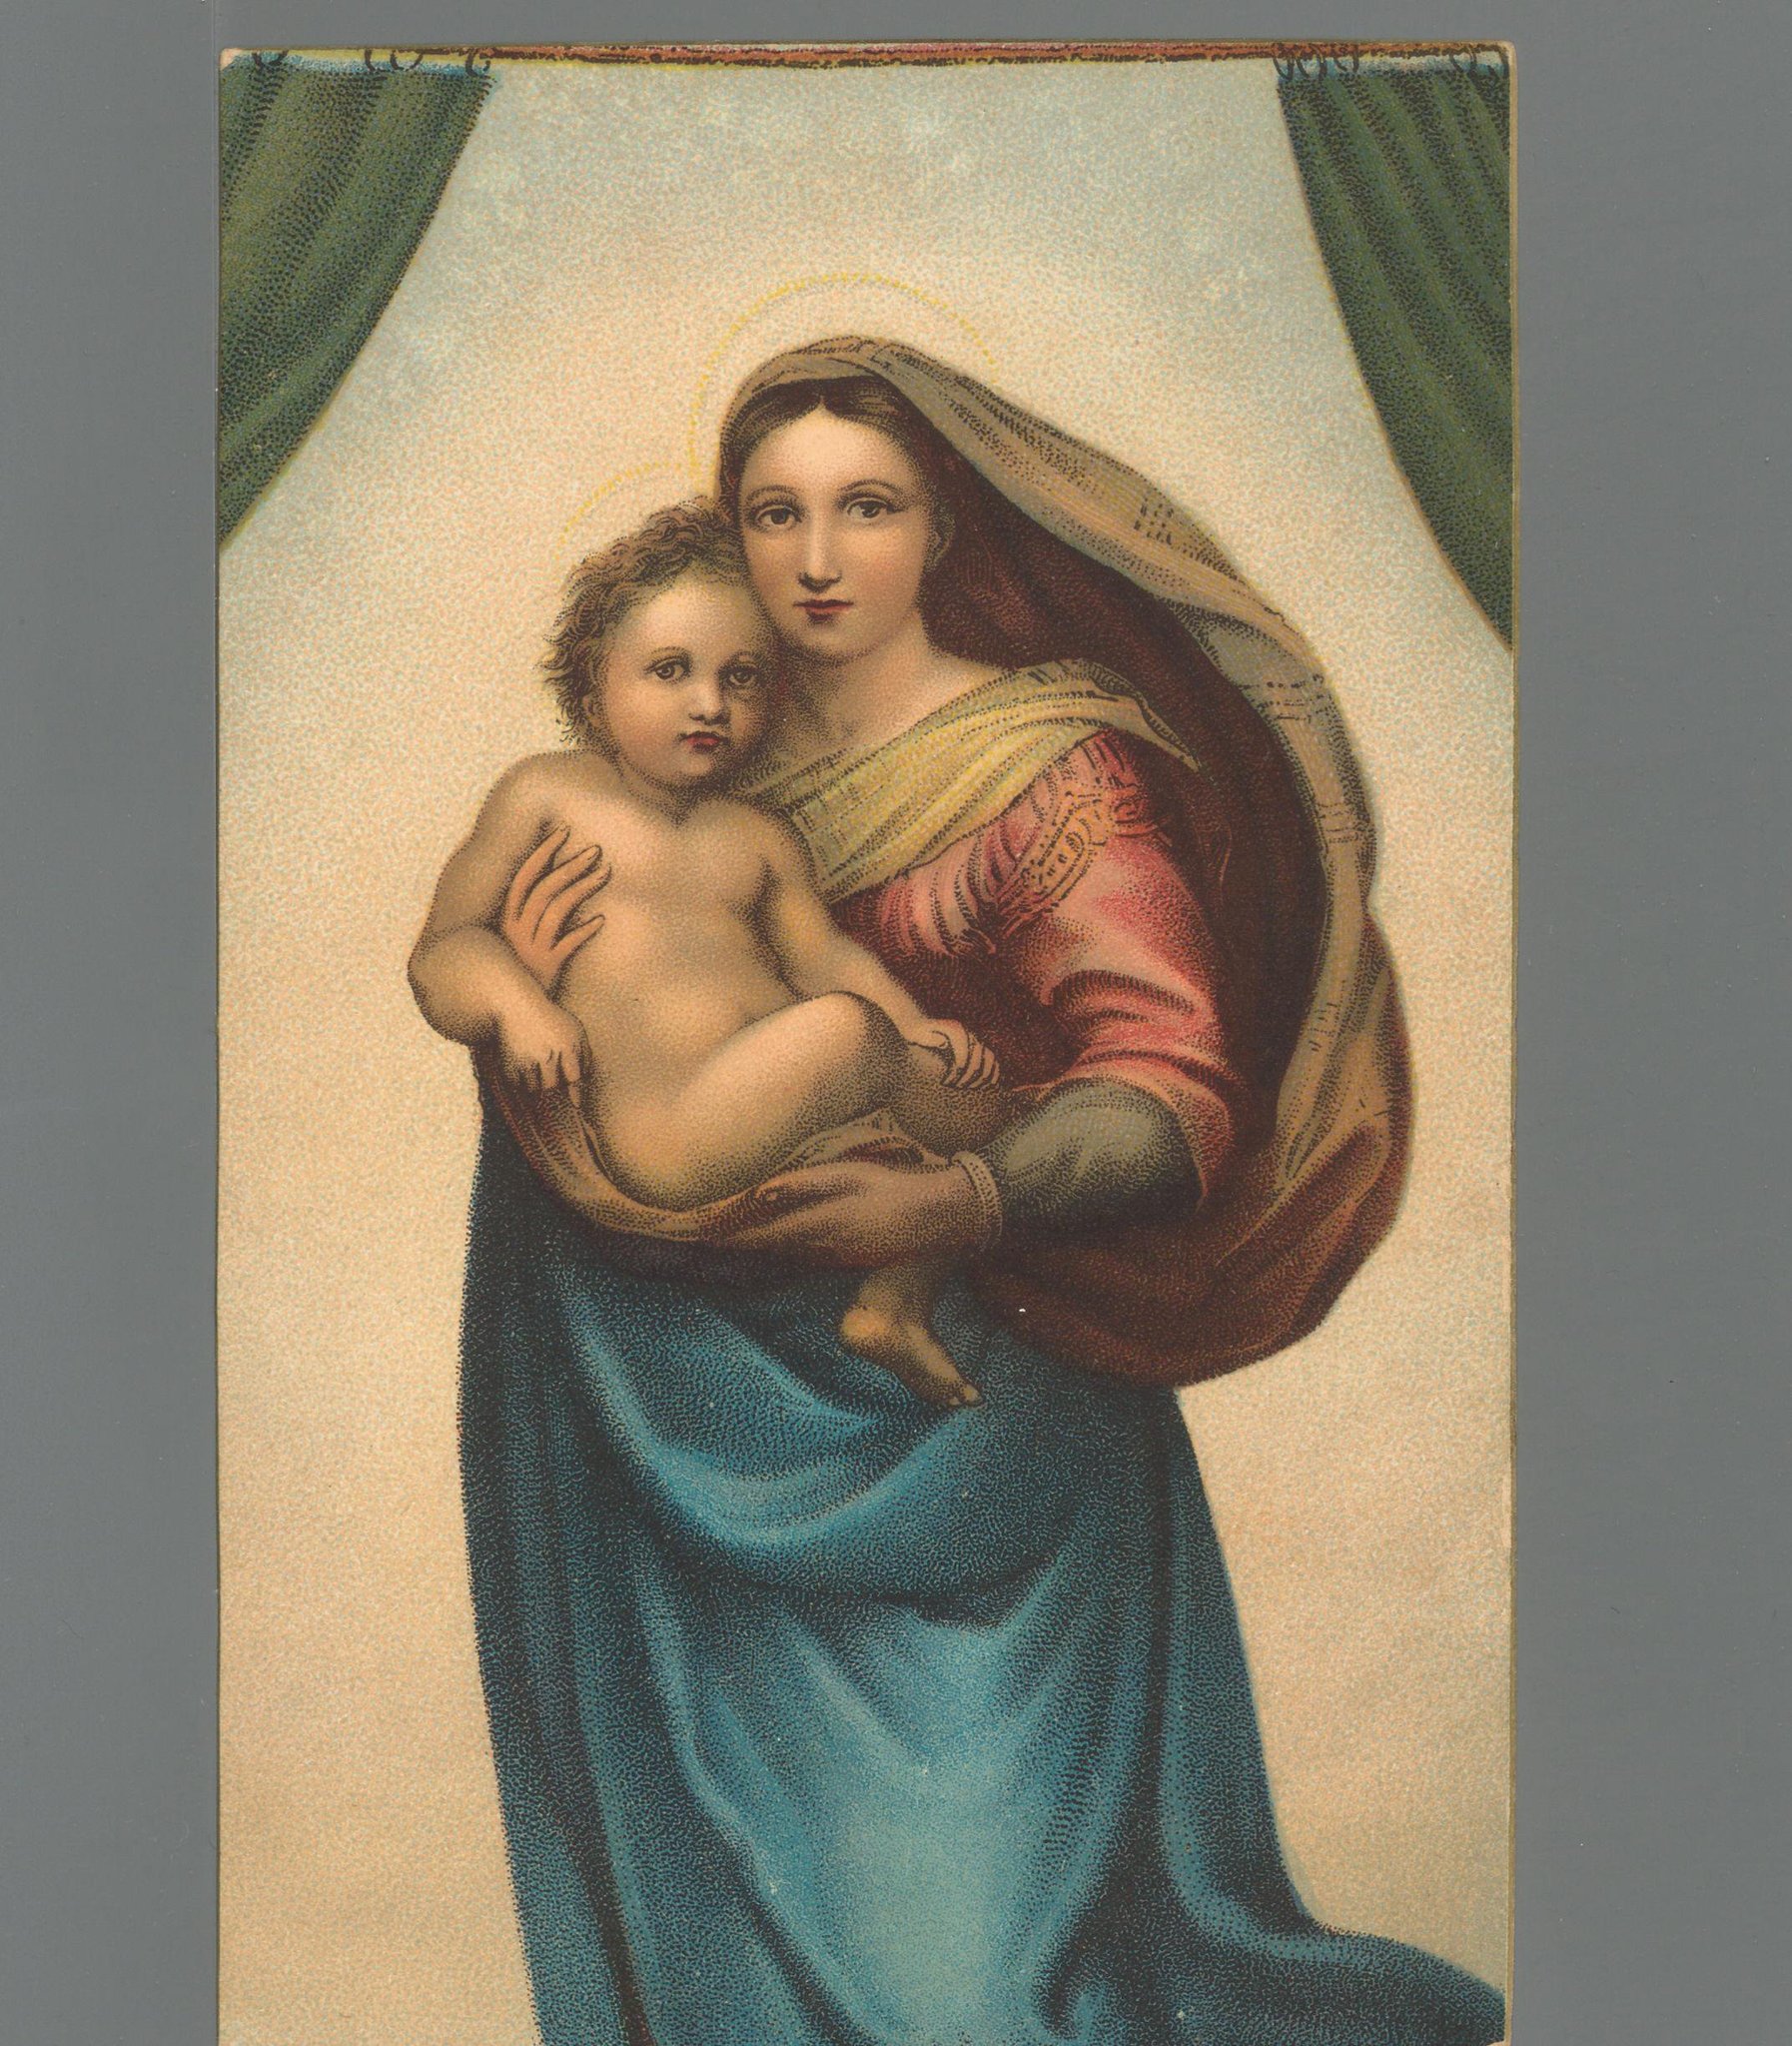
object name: ansichtkaart, prentbriefkaart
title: World's Galleries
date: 1905-1930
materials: cardboard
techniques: lithograph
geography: saxony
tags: series of scenes from the life of mary, permanent exhibition, museum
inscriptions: collector's mark: ‘AFE v S’